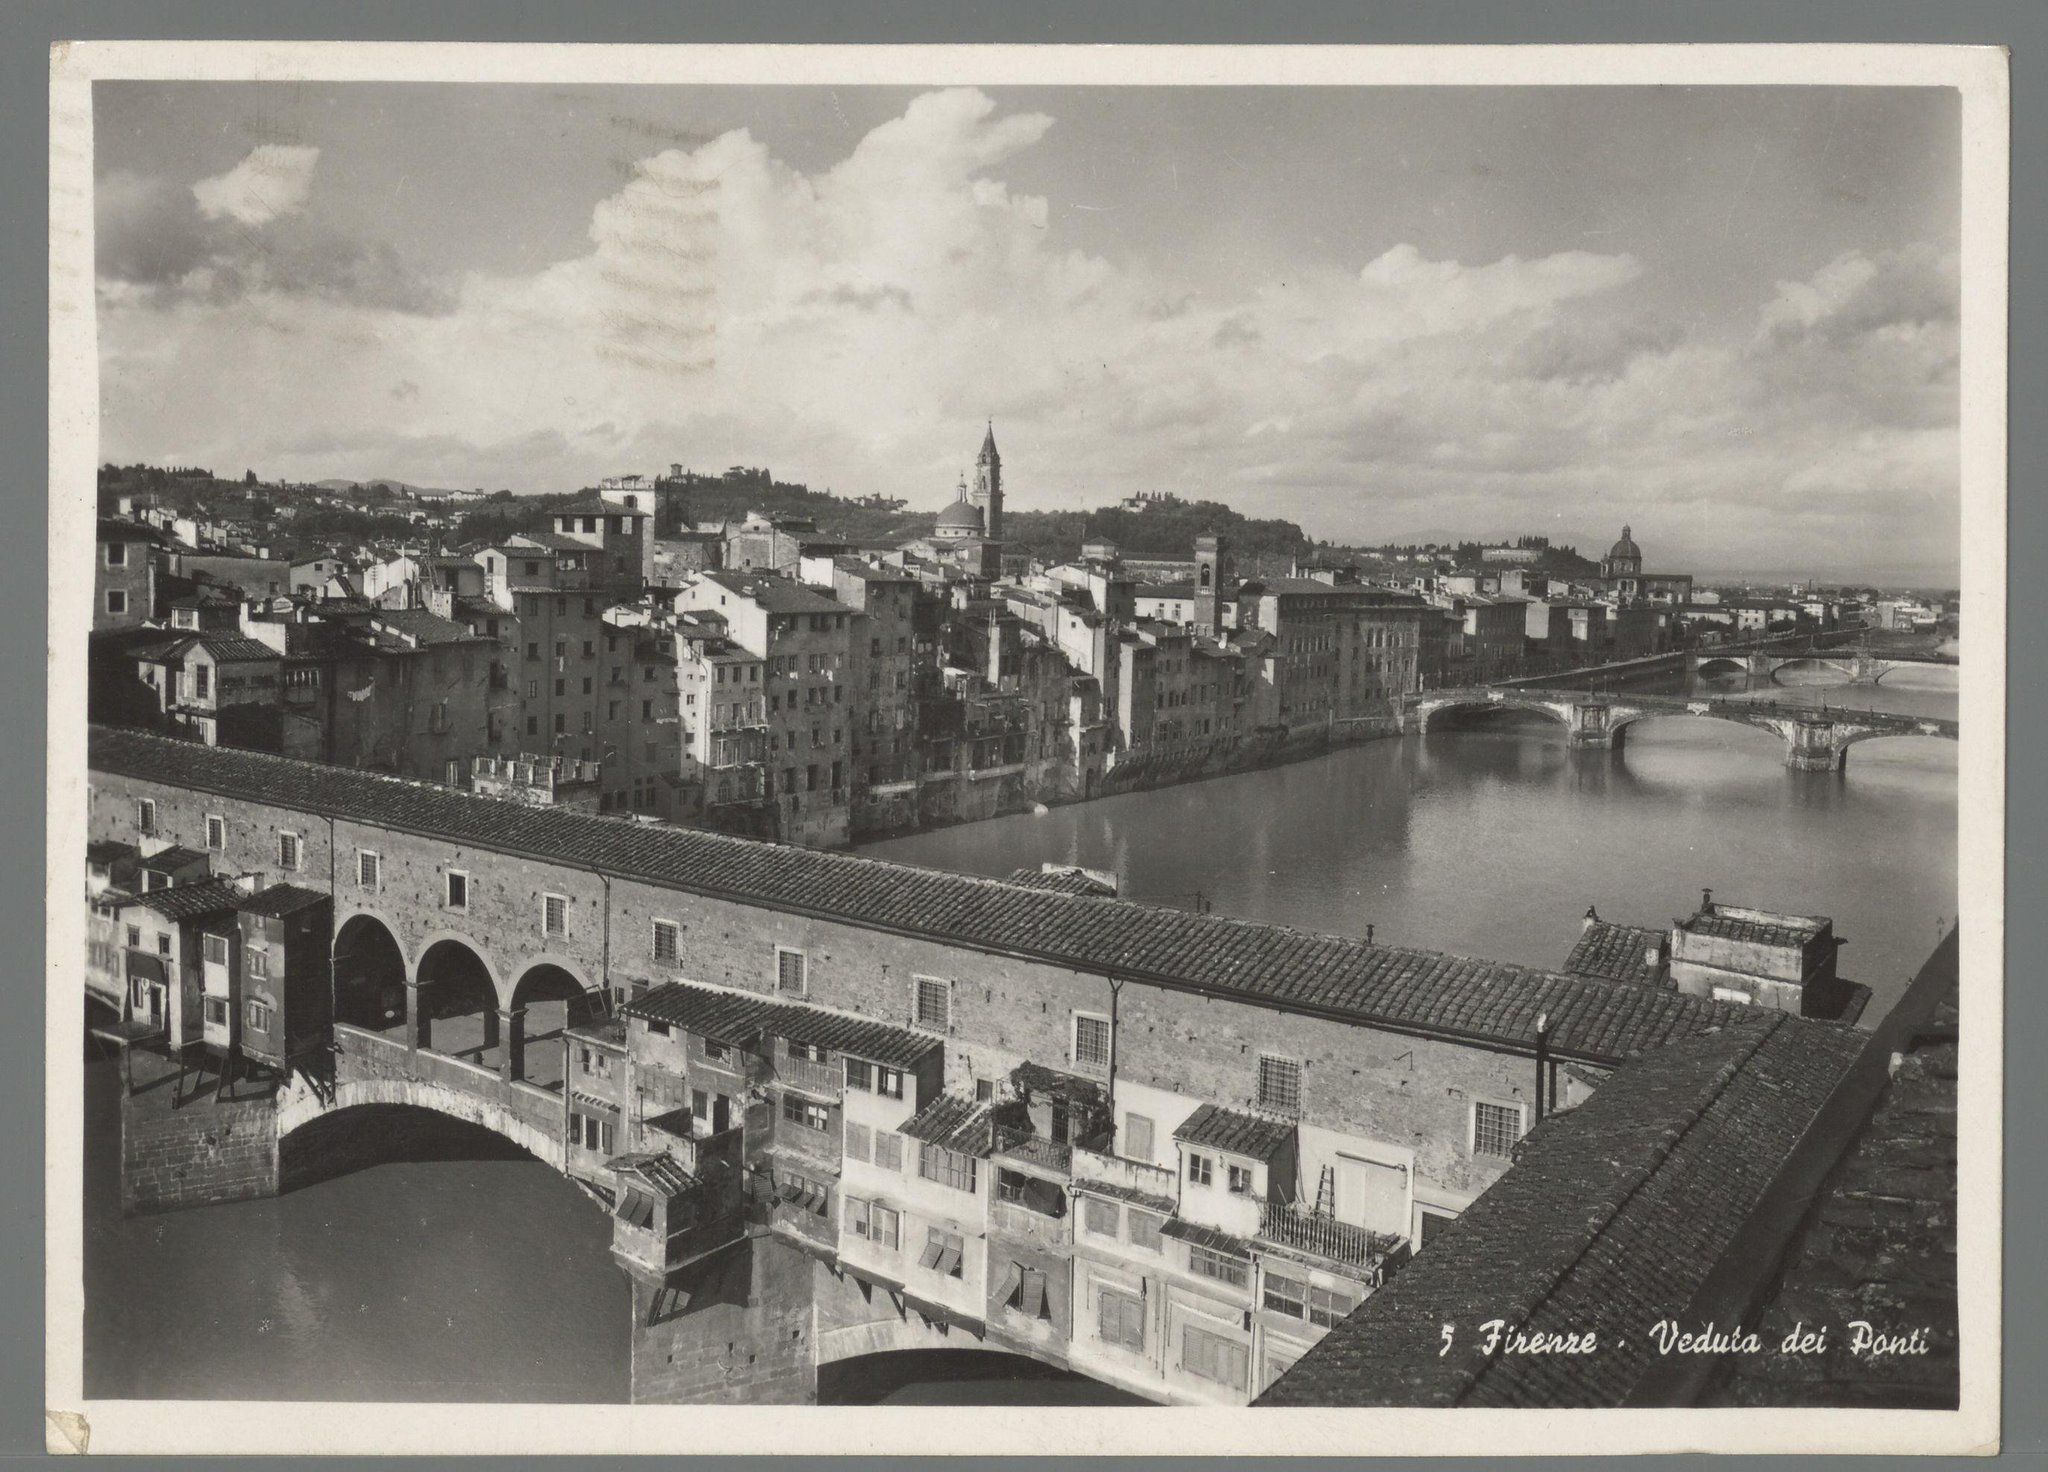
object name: photograph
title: Firenze. Veduta dei Ponti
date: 1929-1947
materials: photographic support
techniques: photography, writing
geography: florence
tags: bridge in city with structures, i.e. shops, houses, e.g. ponte vecchio in florence, city-view, and landscape with man-made constructions (+ city(-scape) with figures, staffage)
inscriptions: postage stamp